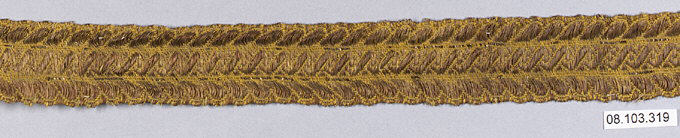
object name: galloon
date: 1601-1800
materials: silk